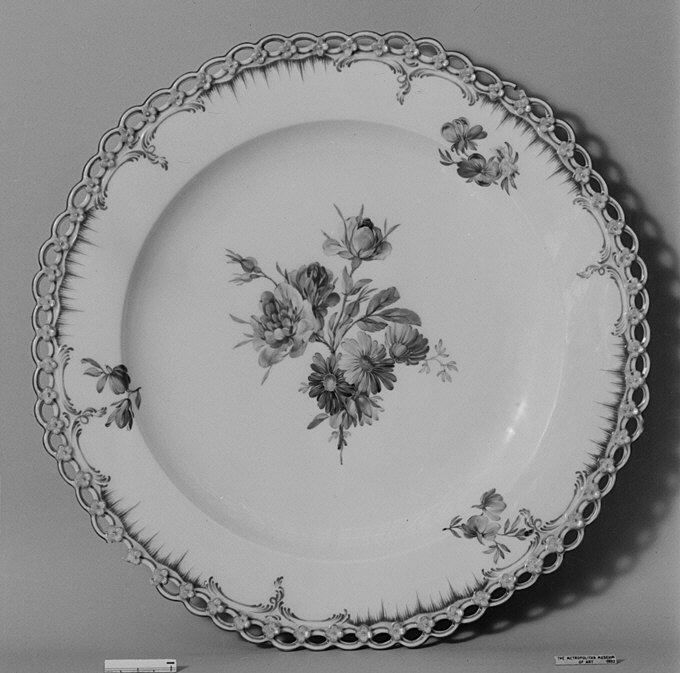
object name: plate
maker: royal porcelain manufactory, berlin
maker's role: manufactory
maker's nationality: german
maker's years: 1763-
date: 1770-1775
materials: hard paste porcelain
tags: flowers